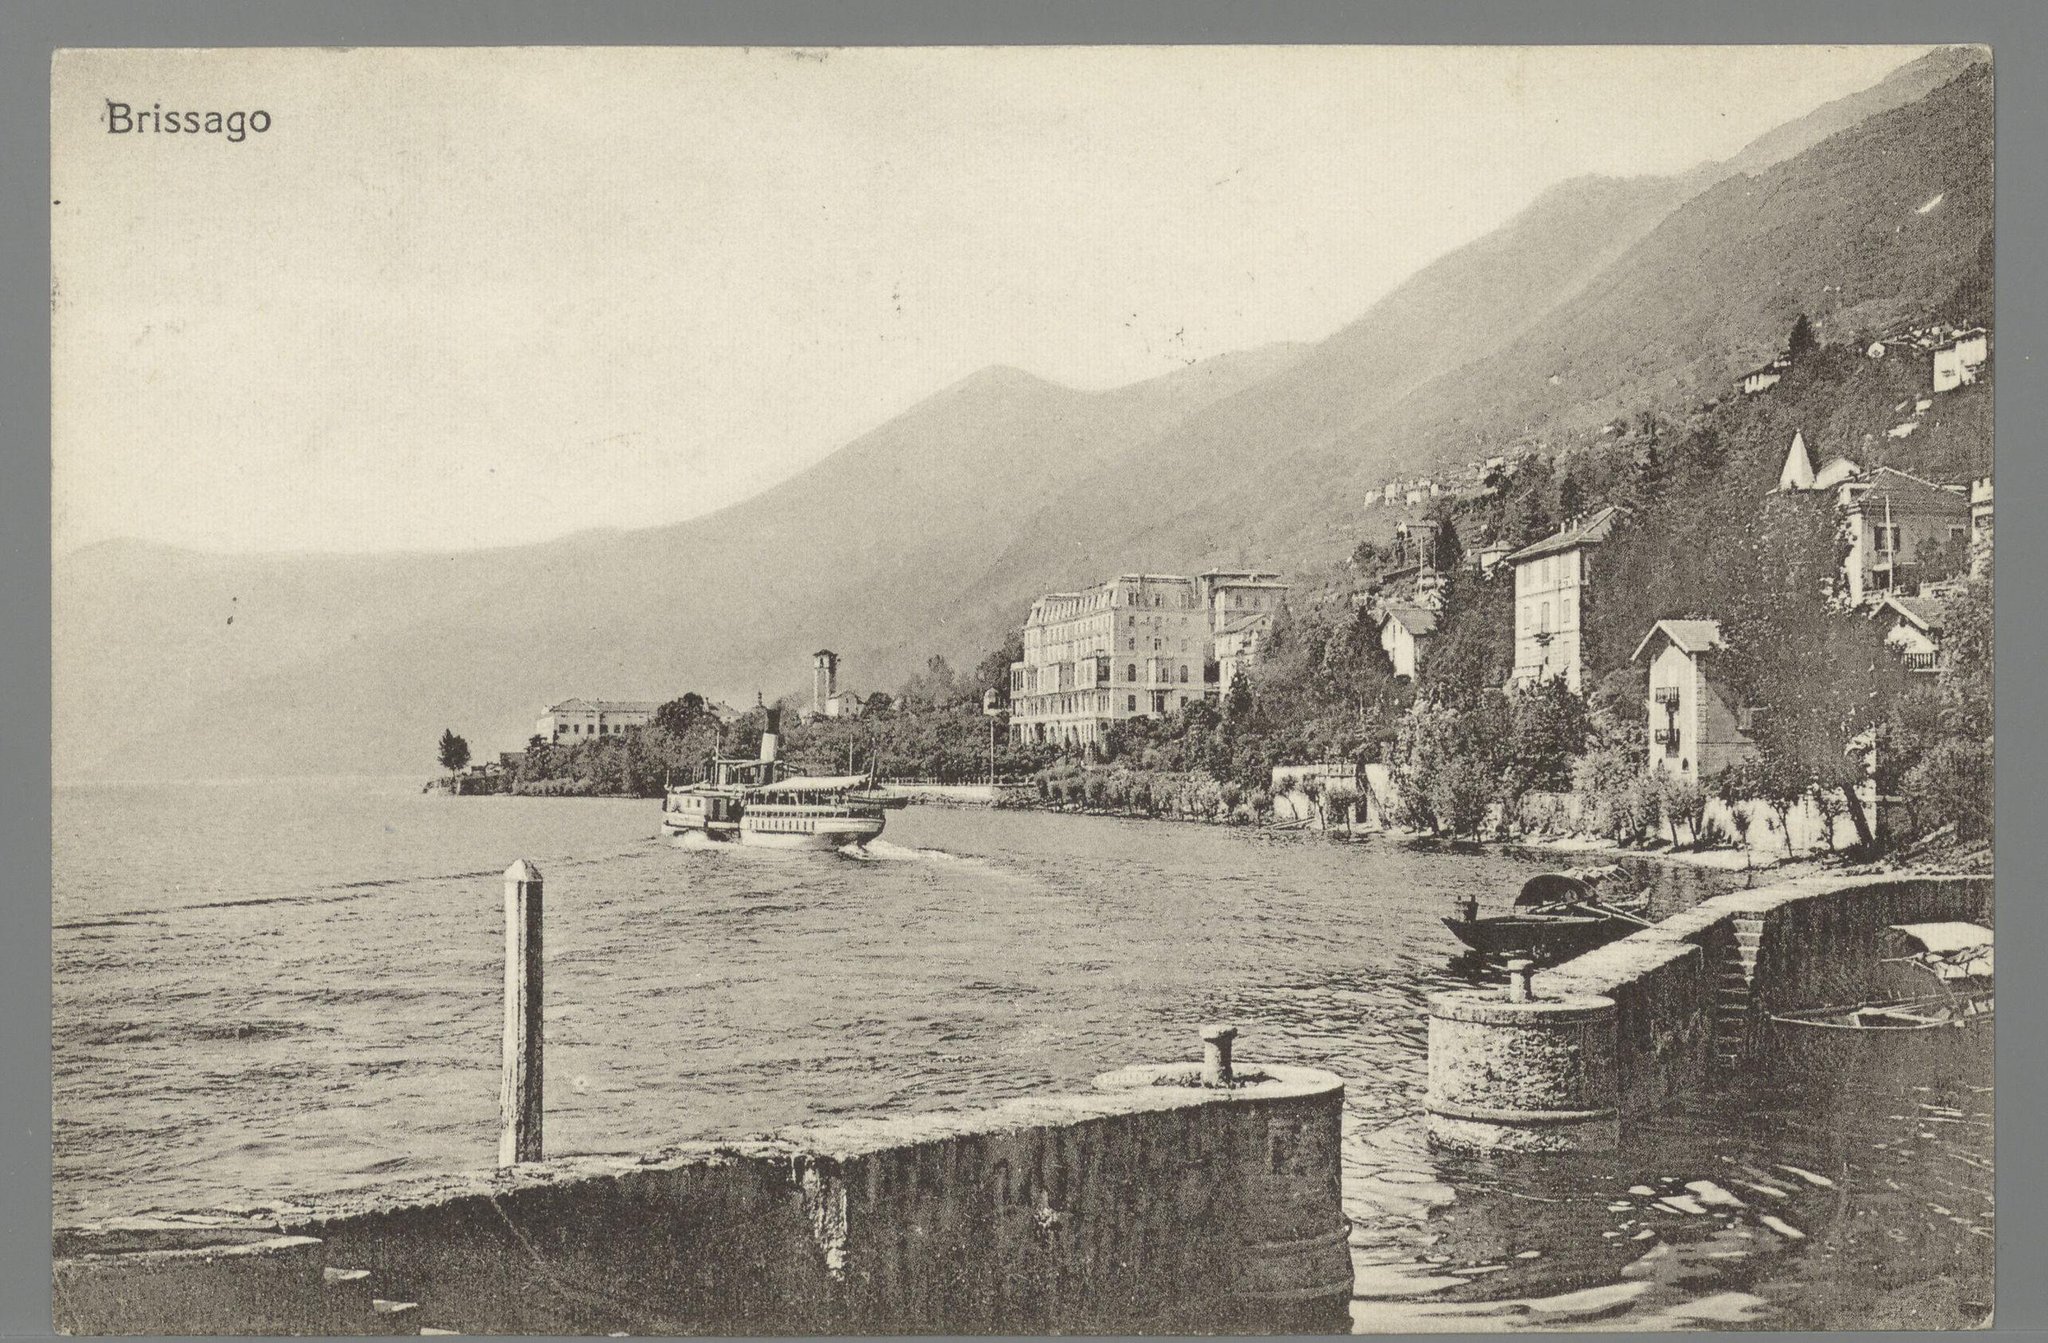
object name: photomechanical print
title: Brissago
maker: Anonymous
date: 1905-1921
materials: cardboard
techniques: photograph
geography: brissago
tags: prospect of village, silhouette of village, lake, mountains